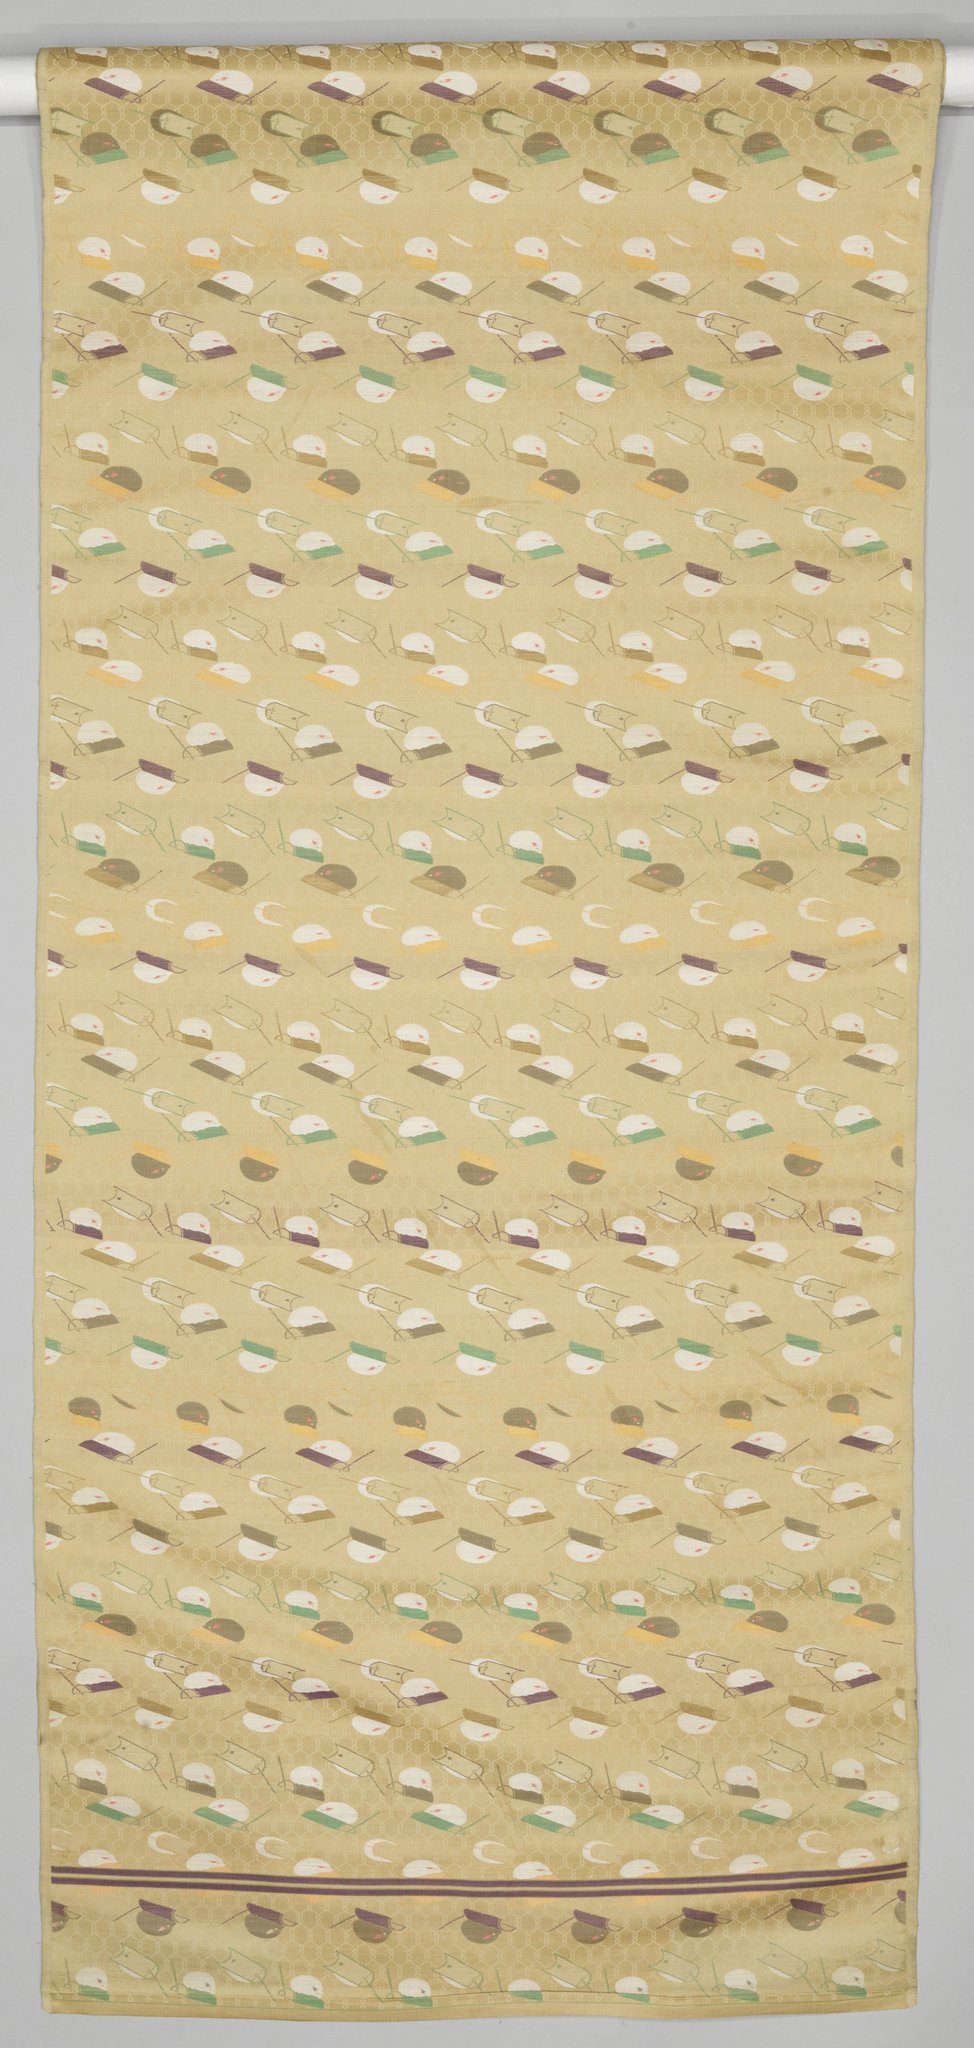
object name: silk textile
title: Baan zijdedamast met een dessin van geschakeld rasterwerk en banen ornament van lampionnen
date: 1900-1920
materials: silk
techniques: damask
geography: japan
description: Baan zijdedamast met een dessin van geschakeld rasterwerk in goudgeel op goudgeel fond "waaroverheen" banen met een ornament van lampionnen in groen, bruin, oranje en paars met zilverwit en rood accent. Oosters textiel.